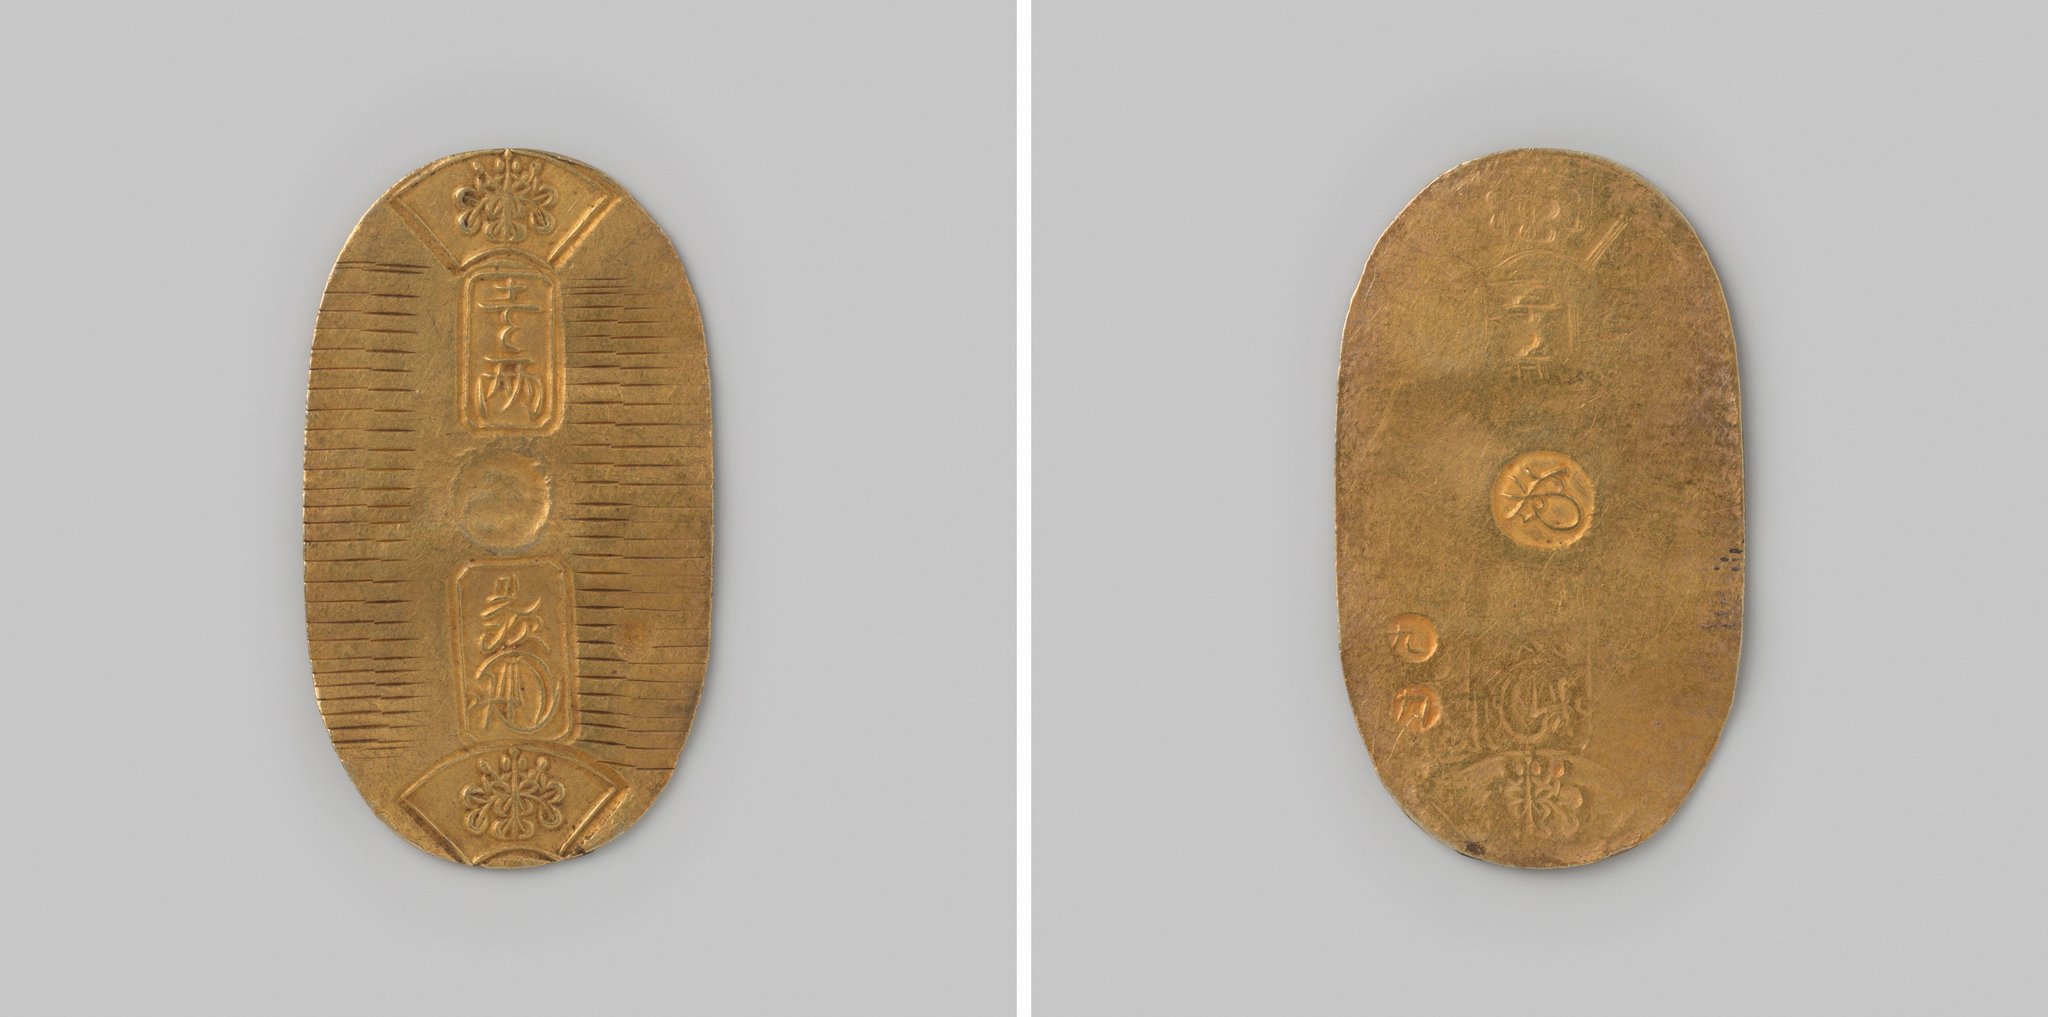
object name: coin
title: Koban van het keizerrijk Japan van keizer Komei uit het Manen tijdperk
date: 1860-1861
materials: gold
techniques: striking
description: Gouden langwerpige munt met afgeronde hoeken. Voorzijde: aan uiteinden boven en onderaan een bloemmotief, naar elkaar toegewend, waartussen in twee rechthoeken tekens. Keerzijde: in het midden bloemmotief met autorisatie-tekens, zonder aanduiding van het Manen tijdperk.